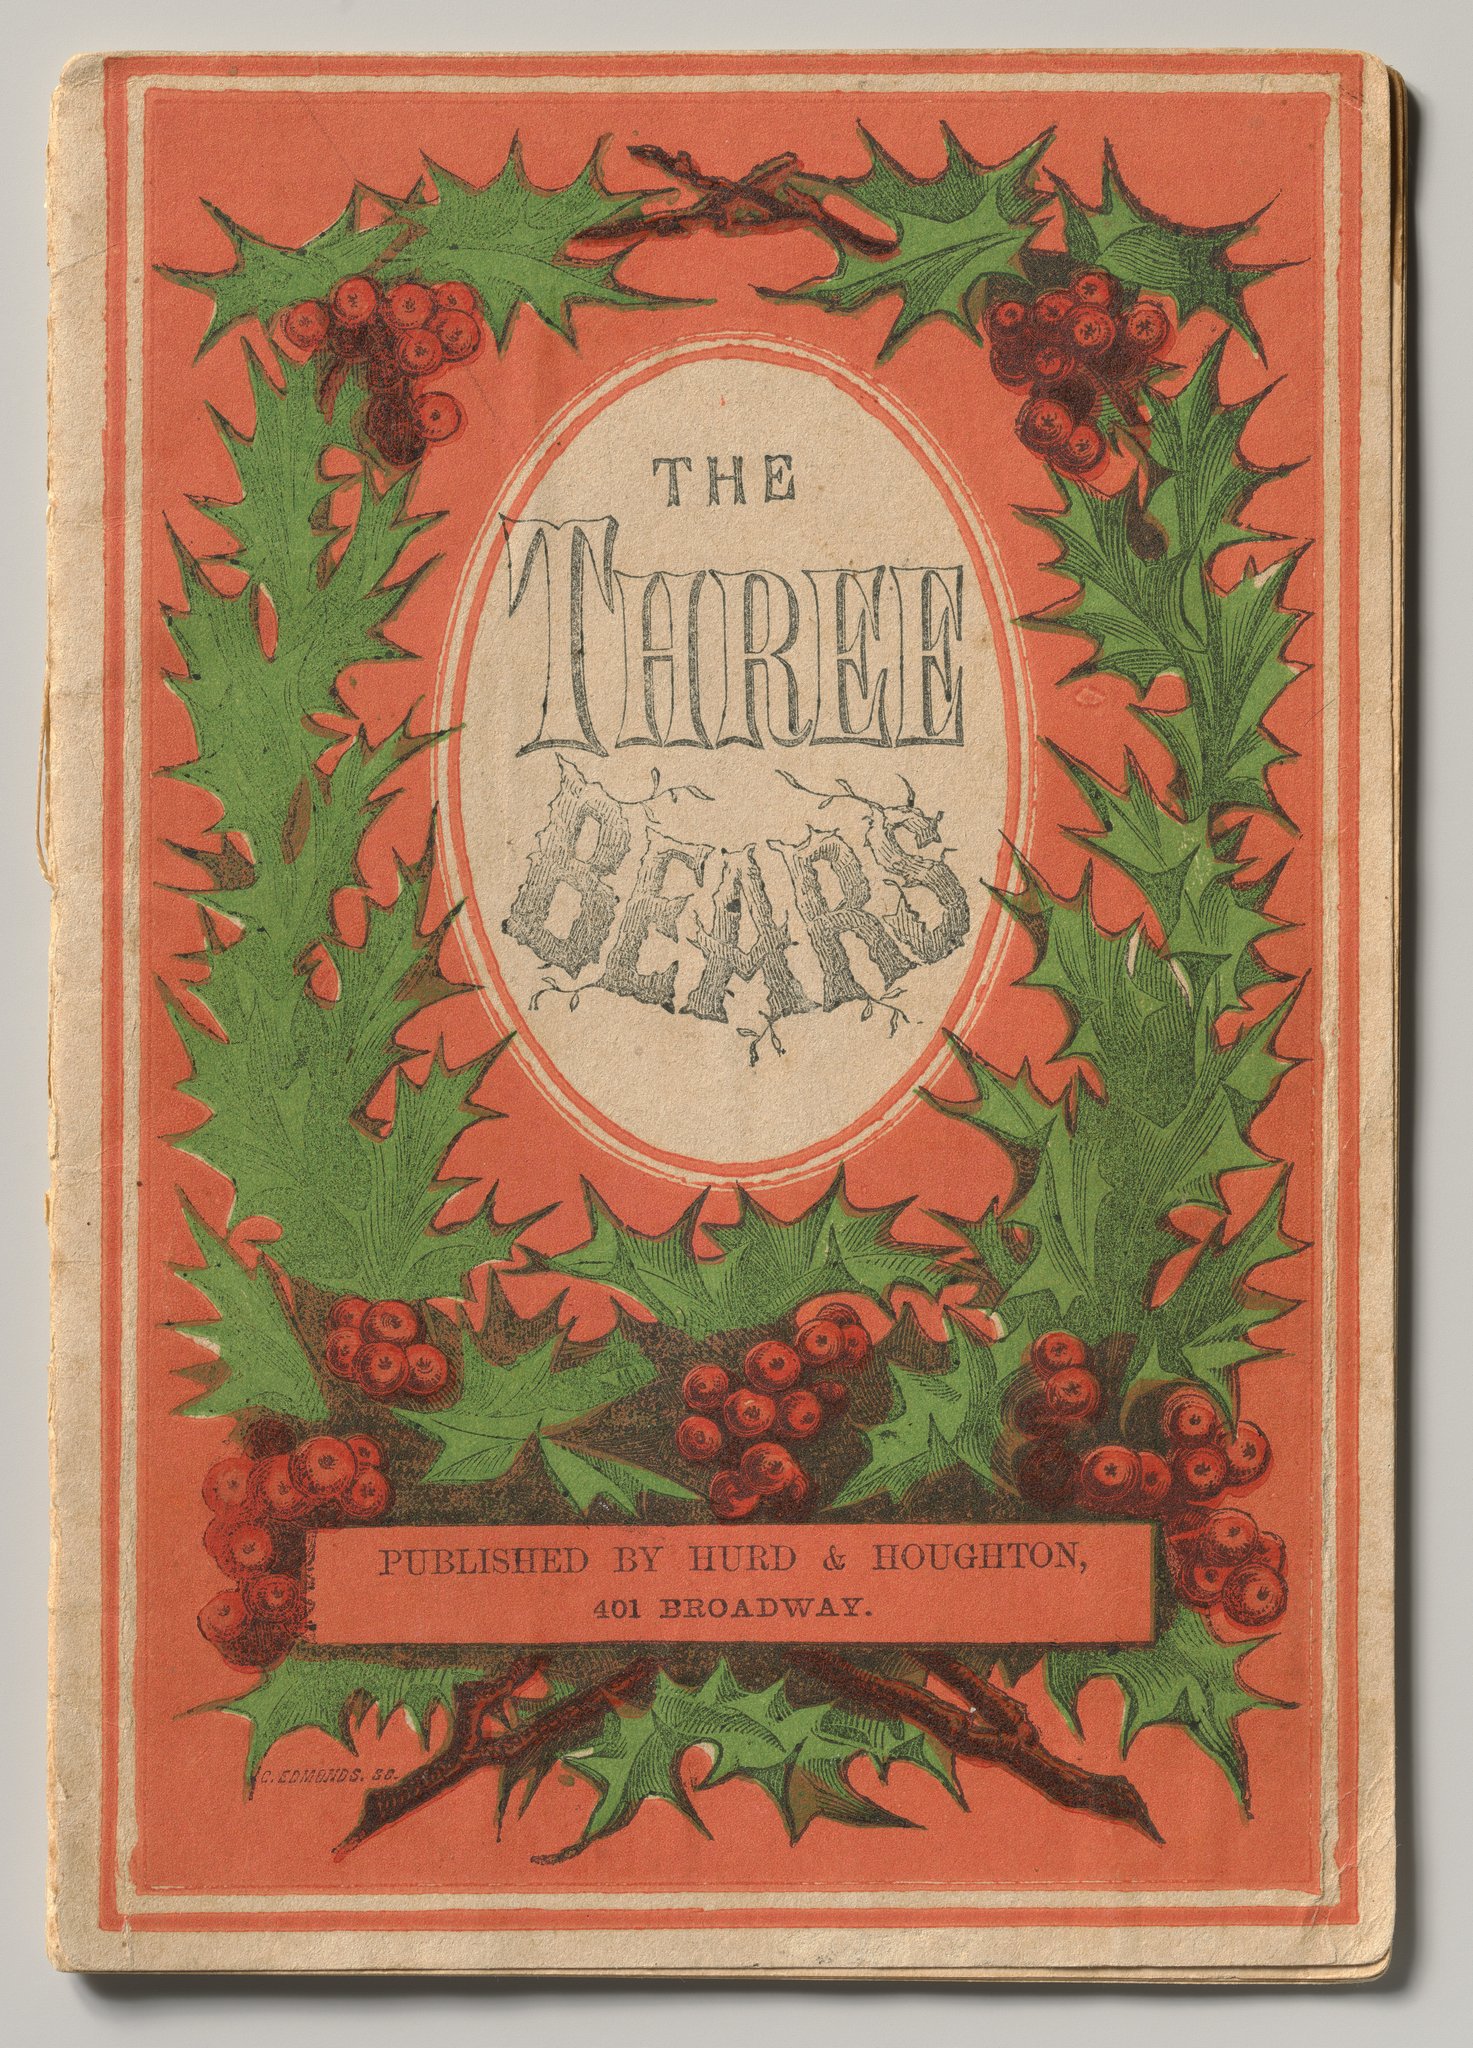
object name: pamphlet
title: The Three Bears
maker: harrison william weir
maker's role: artist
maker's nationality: british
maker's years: 1824-1906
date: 1851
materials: oil, wood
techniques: engraving, lithograph, printing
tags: bears,girls